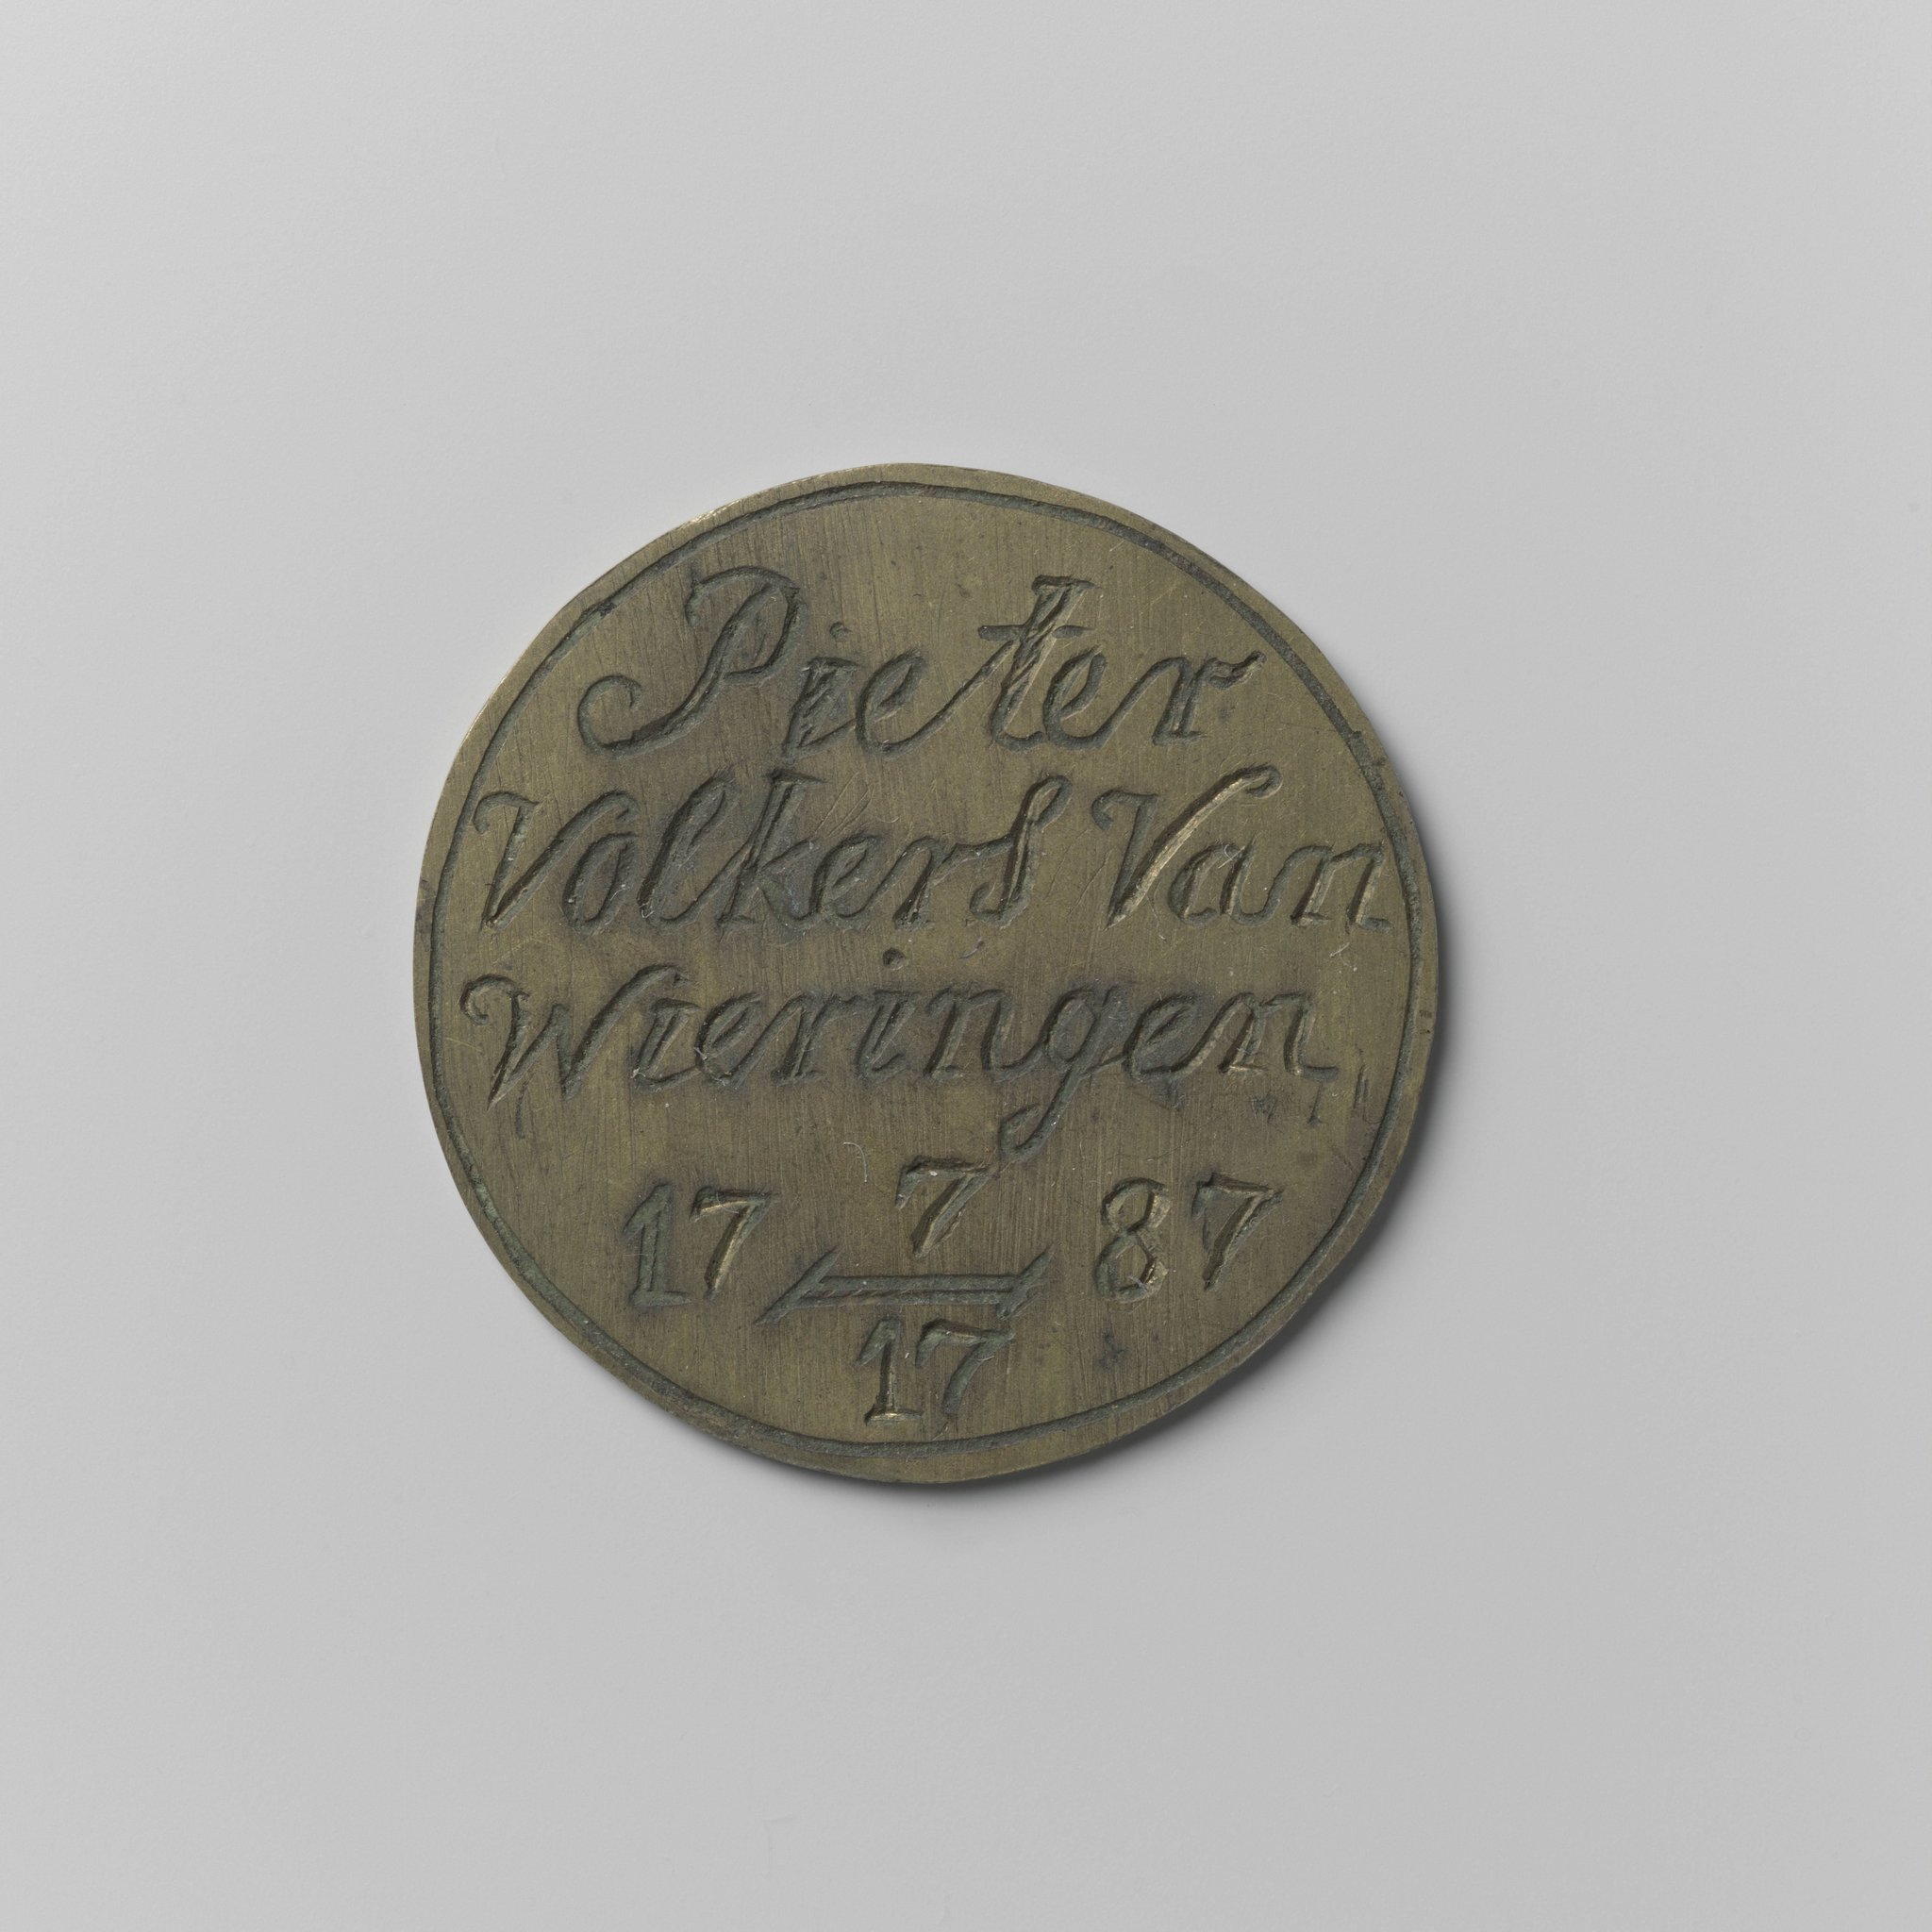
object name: medal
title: Klein binnenlandsvaardersgilde van Amsterdam, gildepenning van Pieter Volkers van Wieringen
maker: Anonymous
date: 1771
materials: brass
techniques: engraving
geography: amsterdam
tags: amsterdam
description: Messing penning. Voorzijde: naar links varend schip; op achterplecht:vlag met wapenschild. Keerzijde: opschrift